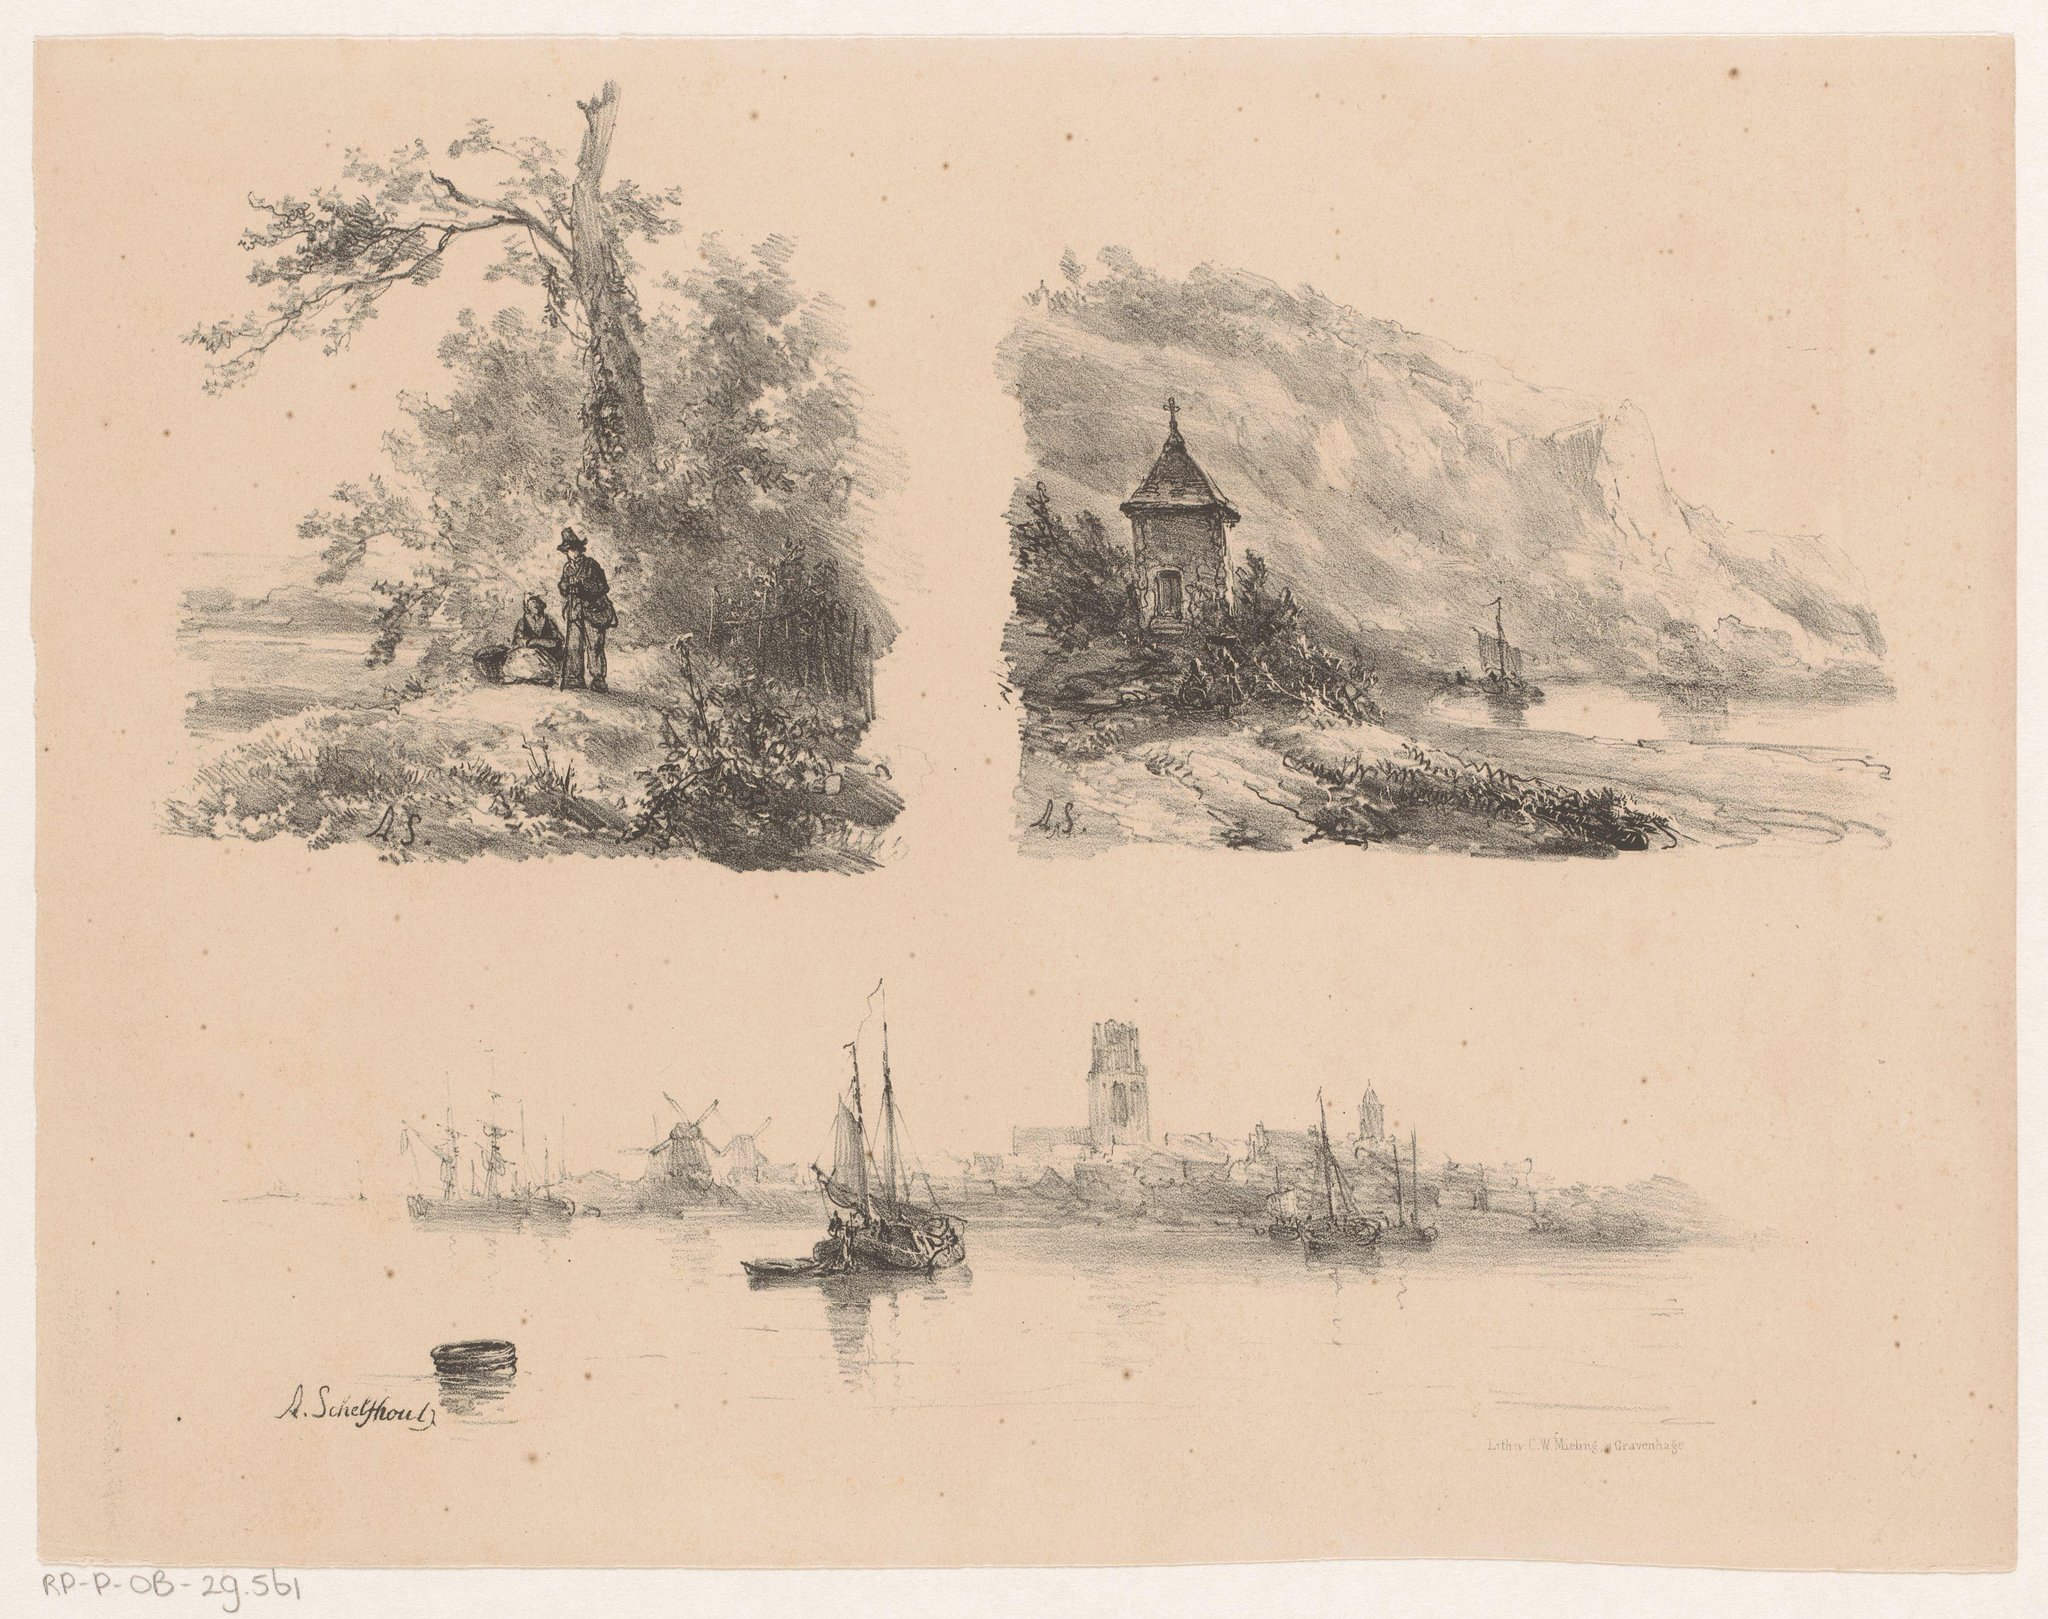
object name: print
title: Figuren in een bos, een rivier langs bergachtige kust en boten op het water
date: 1847-1865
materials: paper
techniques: lithograph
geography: the hague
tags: sailing-ship, sailing-boat, river, forest, wood, dordrecht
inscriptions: collector's mark: Lugt 2228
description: Drie voorstellingen op een blad. Links boven: Een man en vrouw op een heuvel in een bos. Rechts boven: Een rivier met zeilboot langs een bergachtige kust met toren. Onder: Zeilboten op het water met in de achtergrond de stad Dordrecht. Rechts boven genummerd Pl. I.